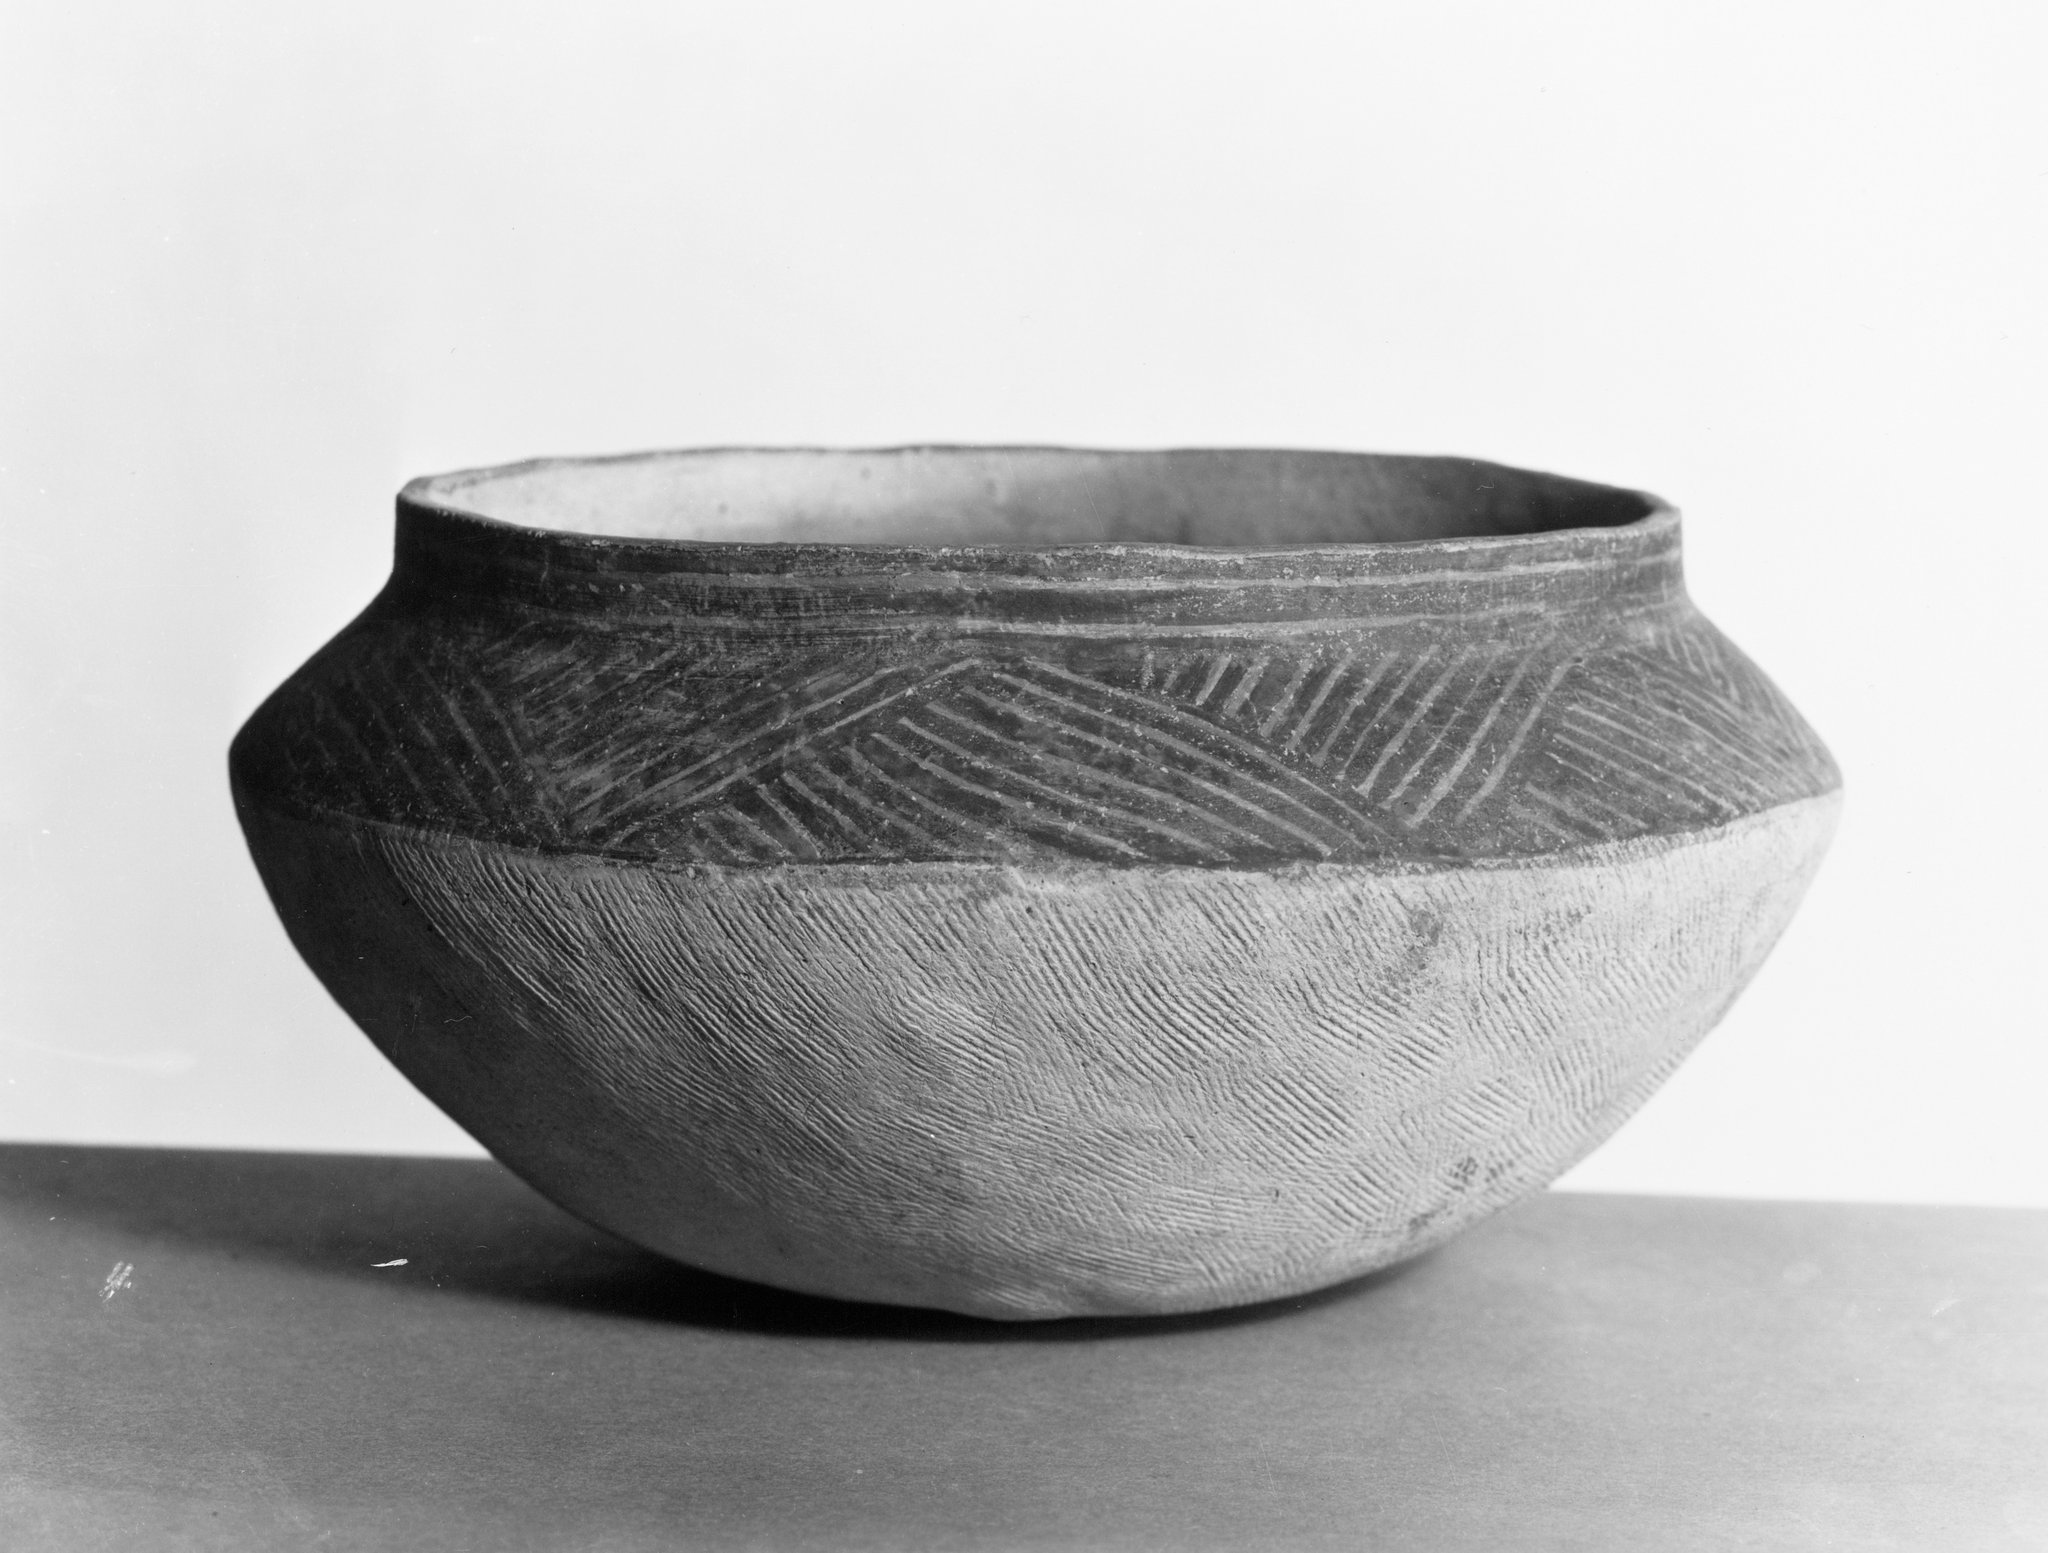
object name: jar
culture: chinese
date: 1000 BCE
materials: cord, earthenware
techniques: painting